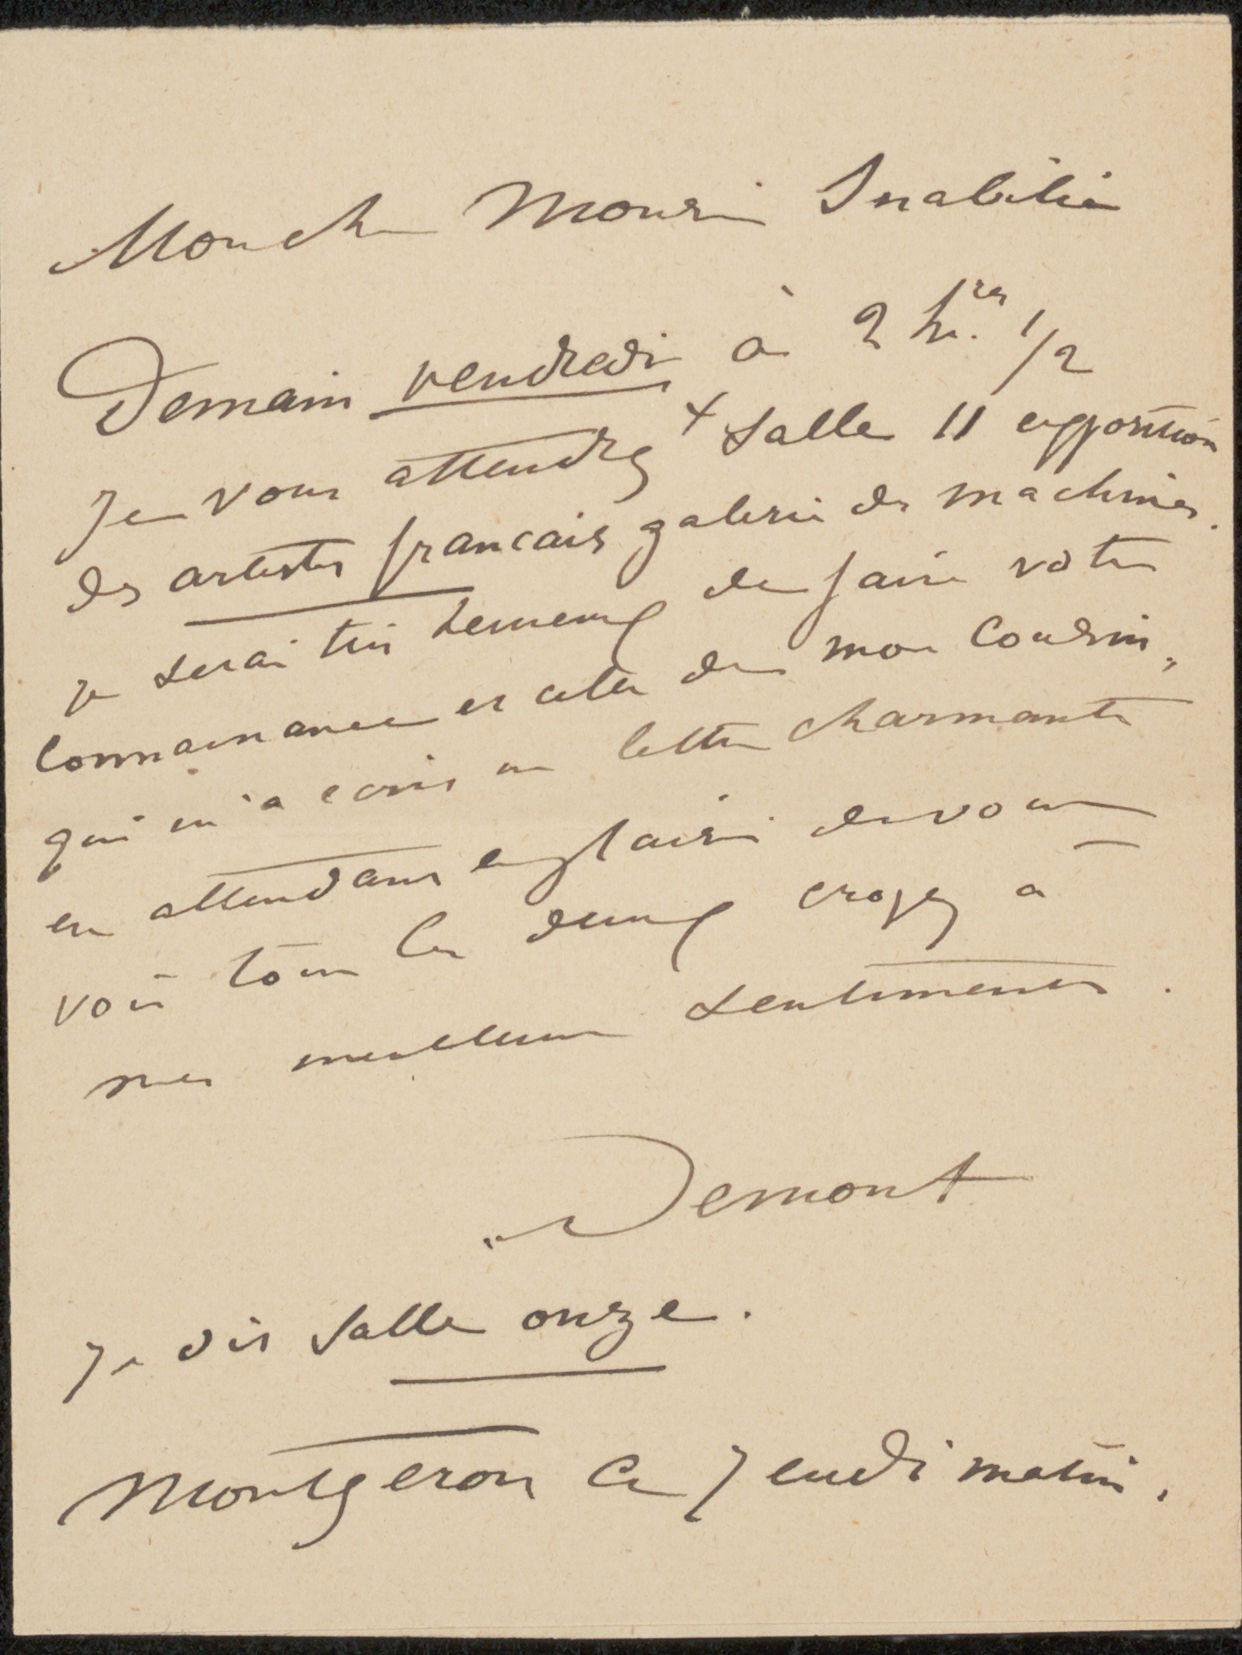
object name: letter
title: Brief aan Philip Zilcken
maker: adrien-louis demont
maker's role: painter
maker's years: 1851-1928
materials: ink, paper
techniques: pen, writing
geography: montgeron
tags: the hague, painter, draughtsman, philip zilcken, exhibition ~ art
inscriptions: watermark, collector's mark: ‘RPK’